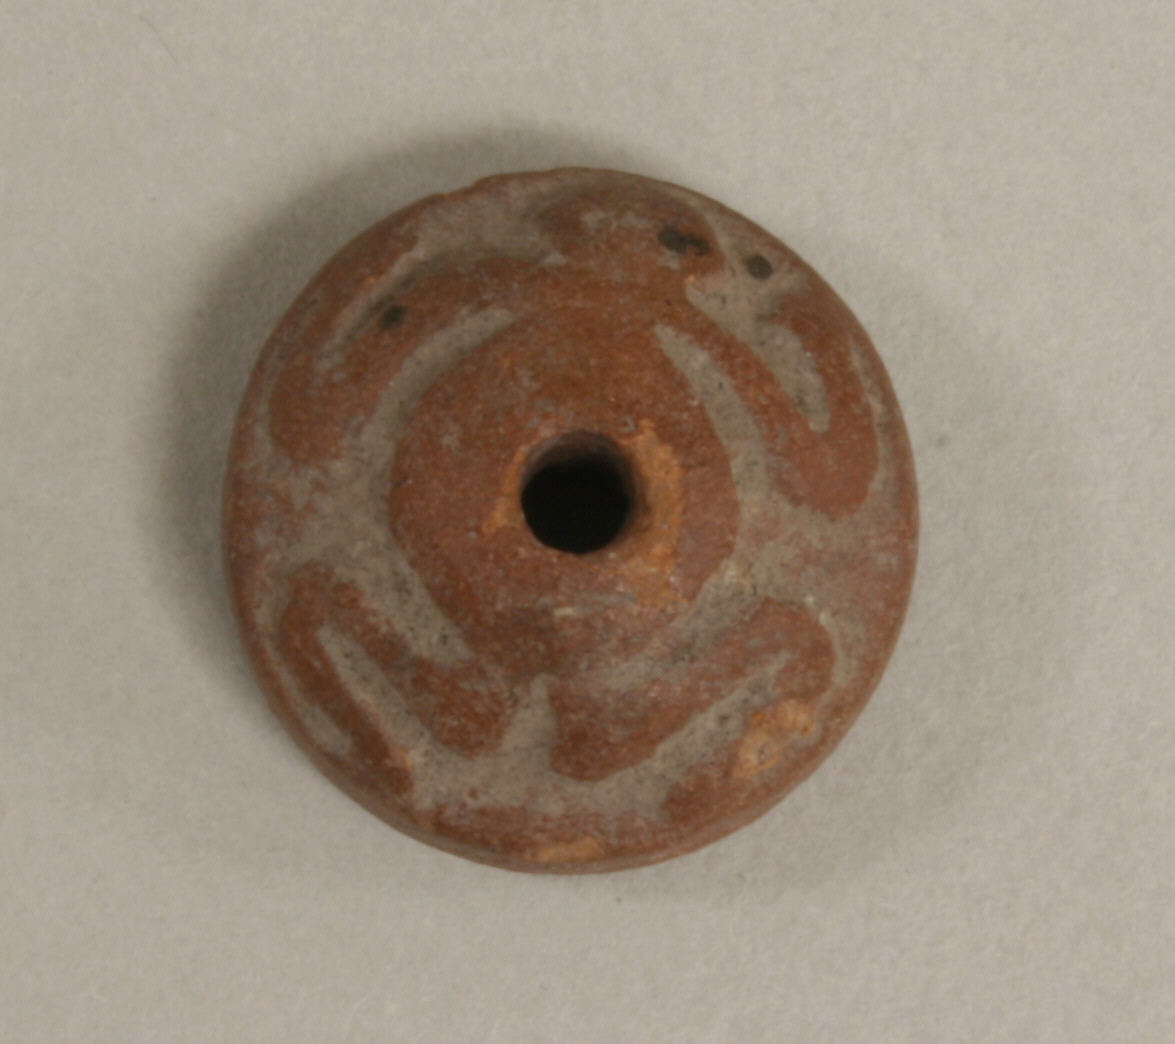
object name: spindle whorl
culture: mexican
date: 801-1500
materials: ceramic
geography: mexico